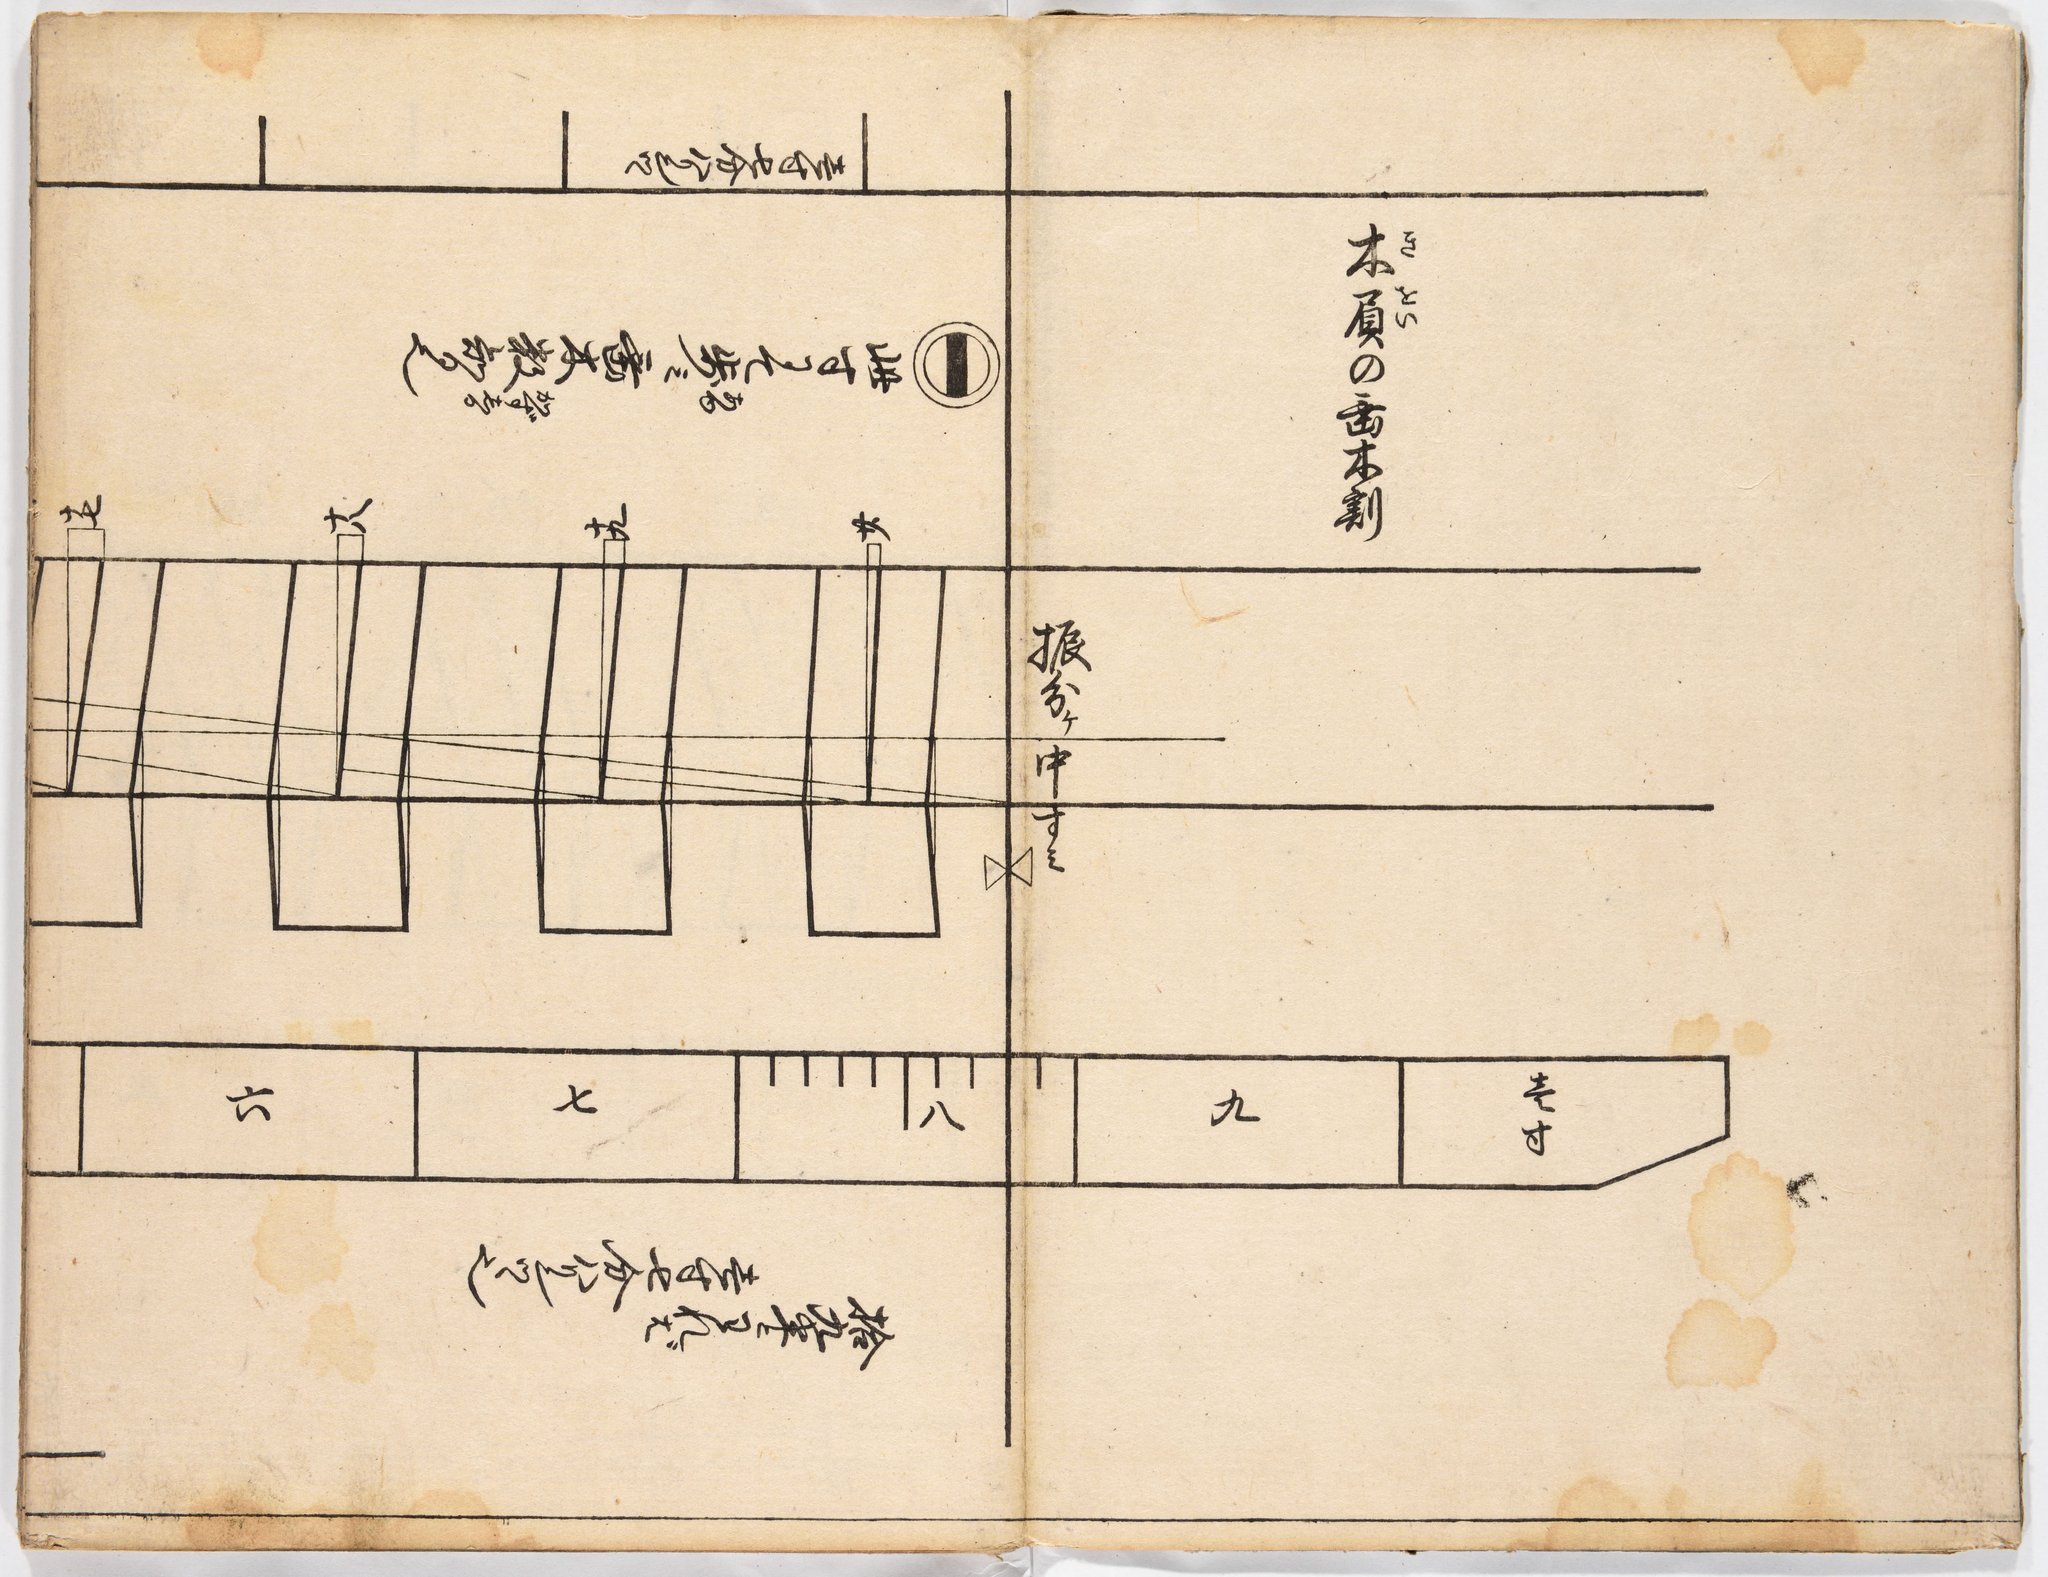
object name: illustrated book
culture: japanese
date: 1893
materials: ink, paper